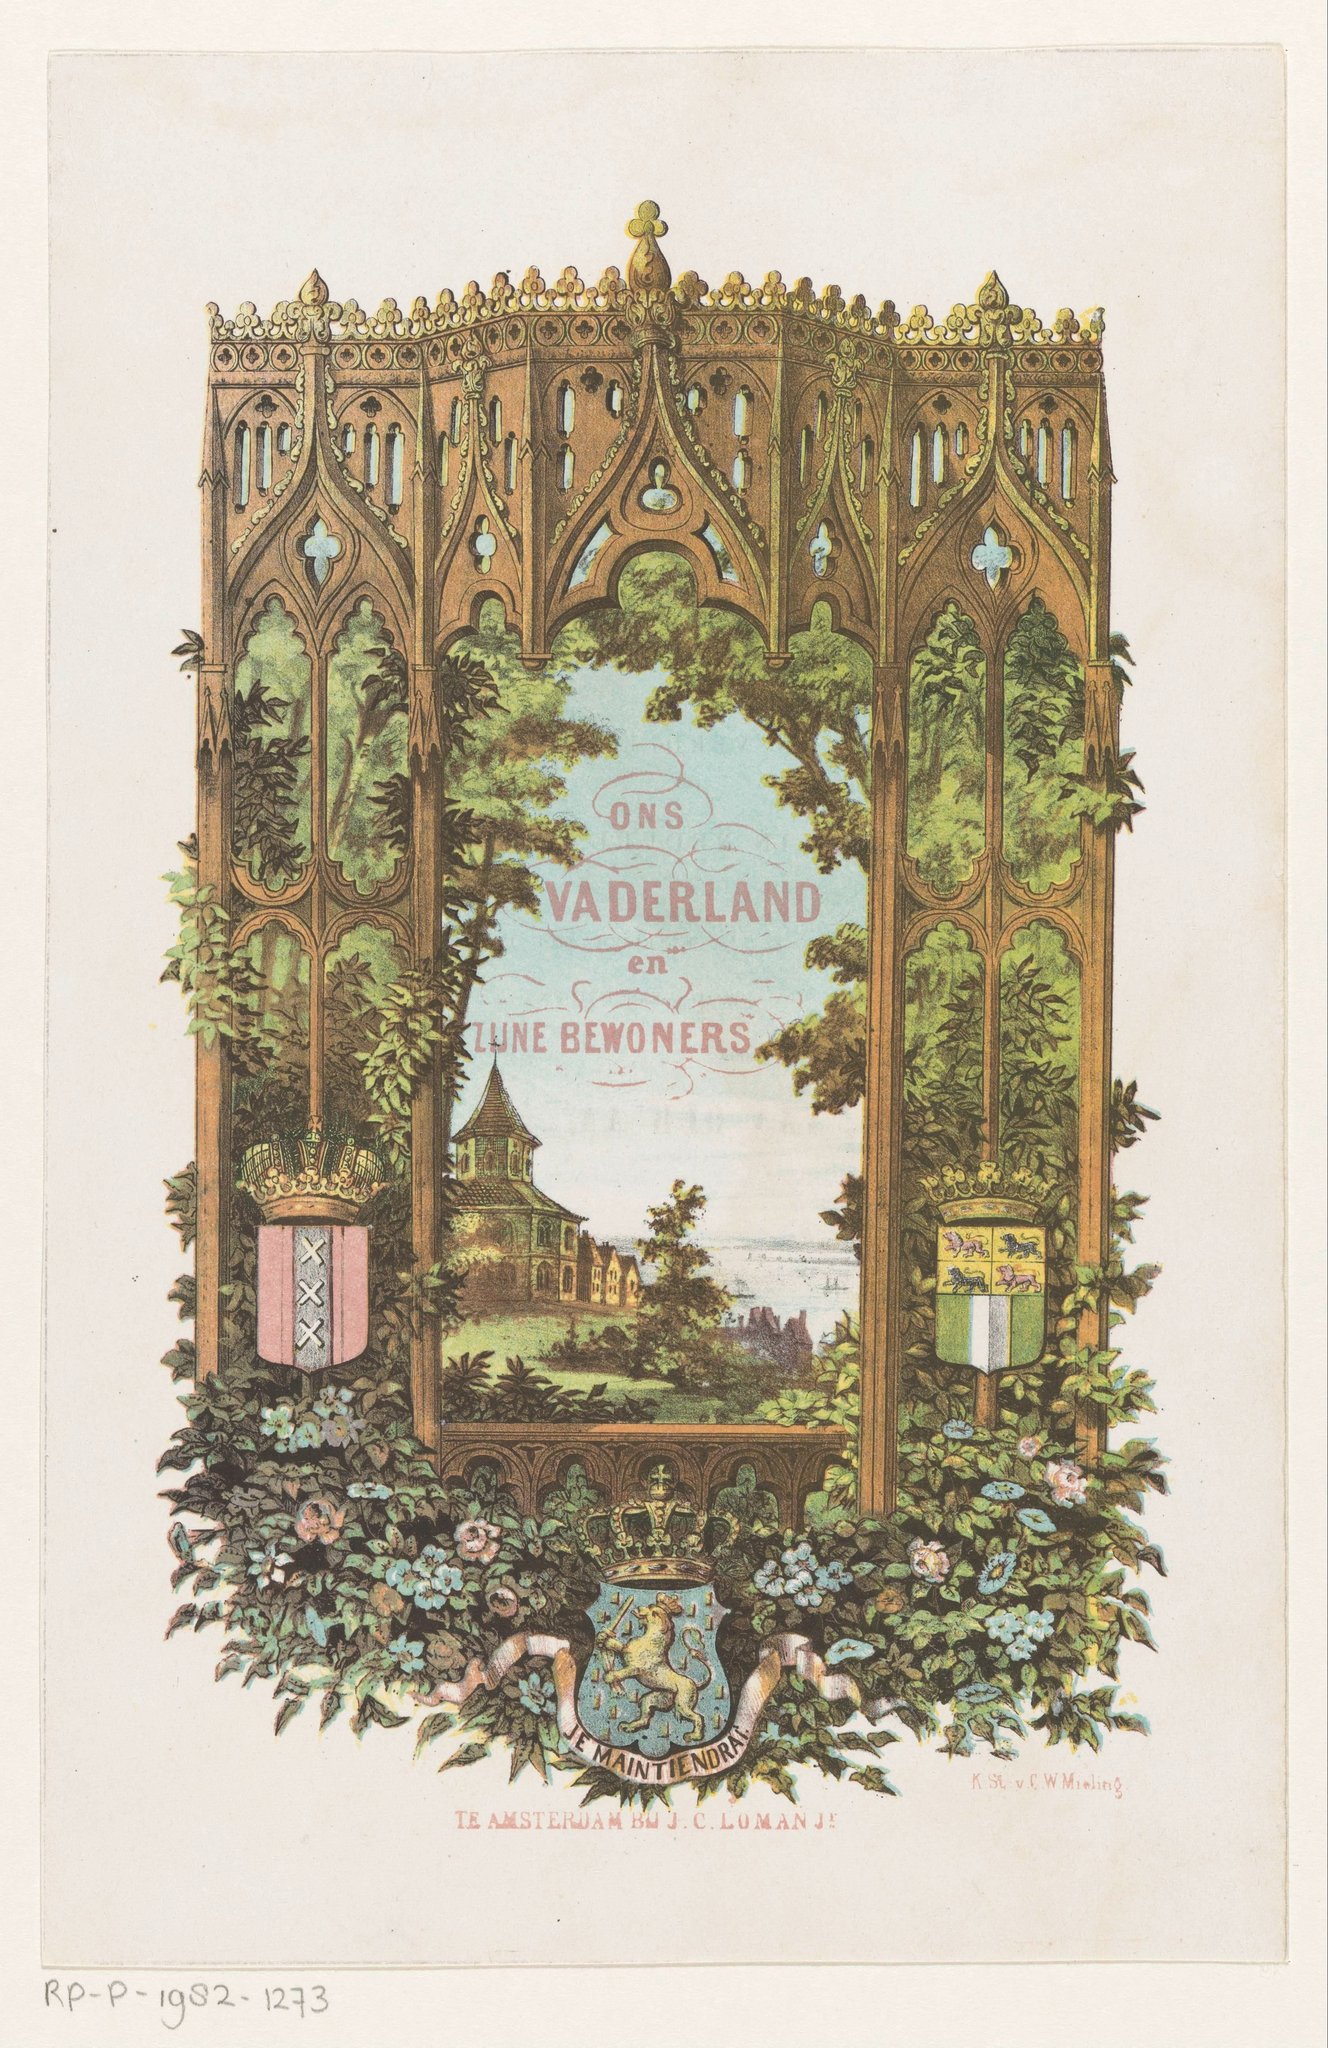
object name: titelblad, titelpagina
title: Doorkijk richting Nederlands landschap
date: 1857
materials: paper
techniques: lithograph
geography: amsterdam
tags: coat of arms (as symbol of the state, etc.), city-view, and landscape with man-made constructions, netherlands, rotterdam, amsterdam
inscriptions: collector's mark: Lugt 2228, collector's mark: Lugt 2760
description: Neogotische doorkijk met bloemen richting een Nederlands landschap aan het water. In de doorkijk drie wapenschilden van Amsterdam, Nederland en Rotterdam.